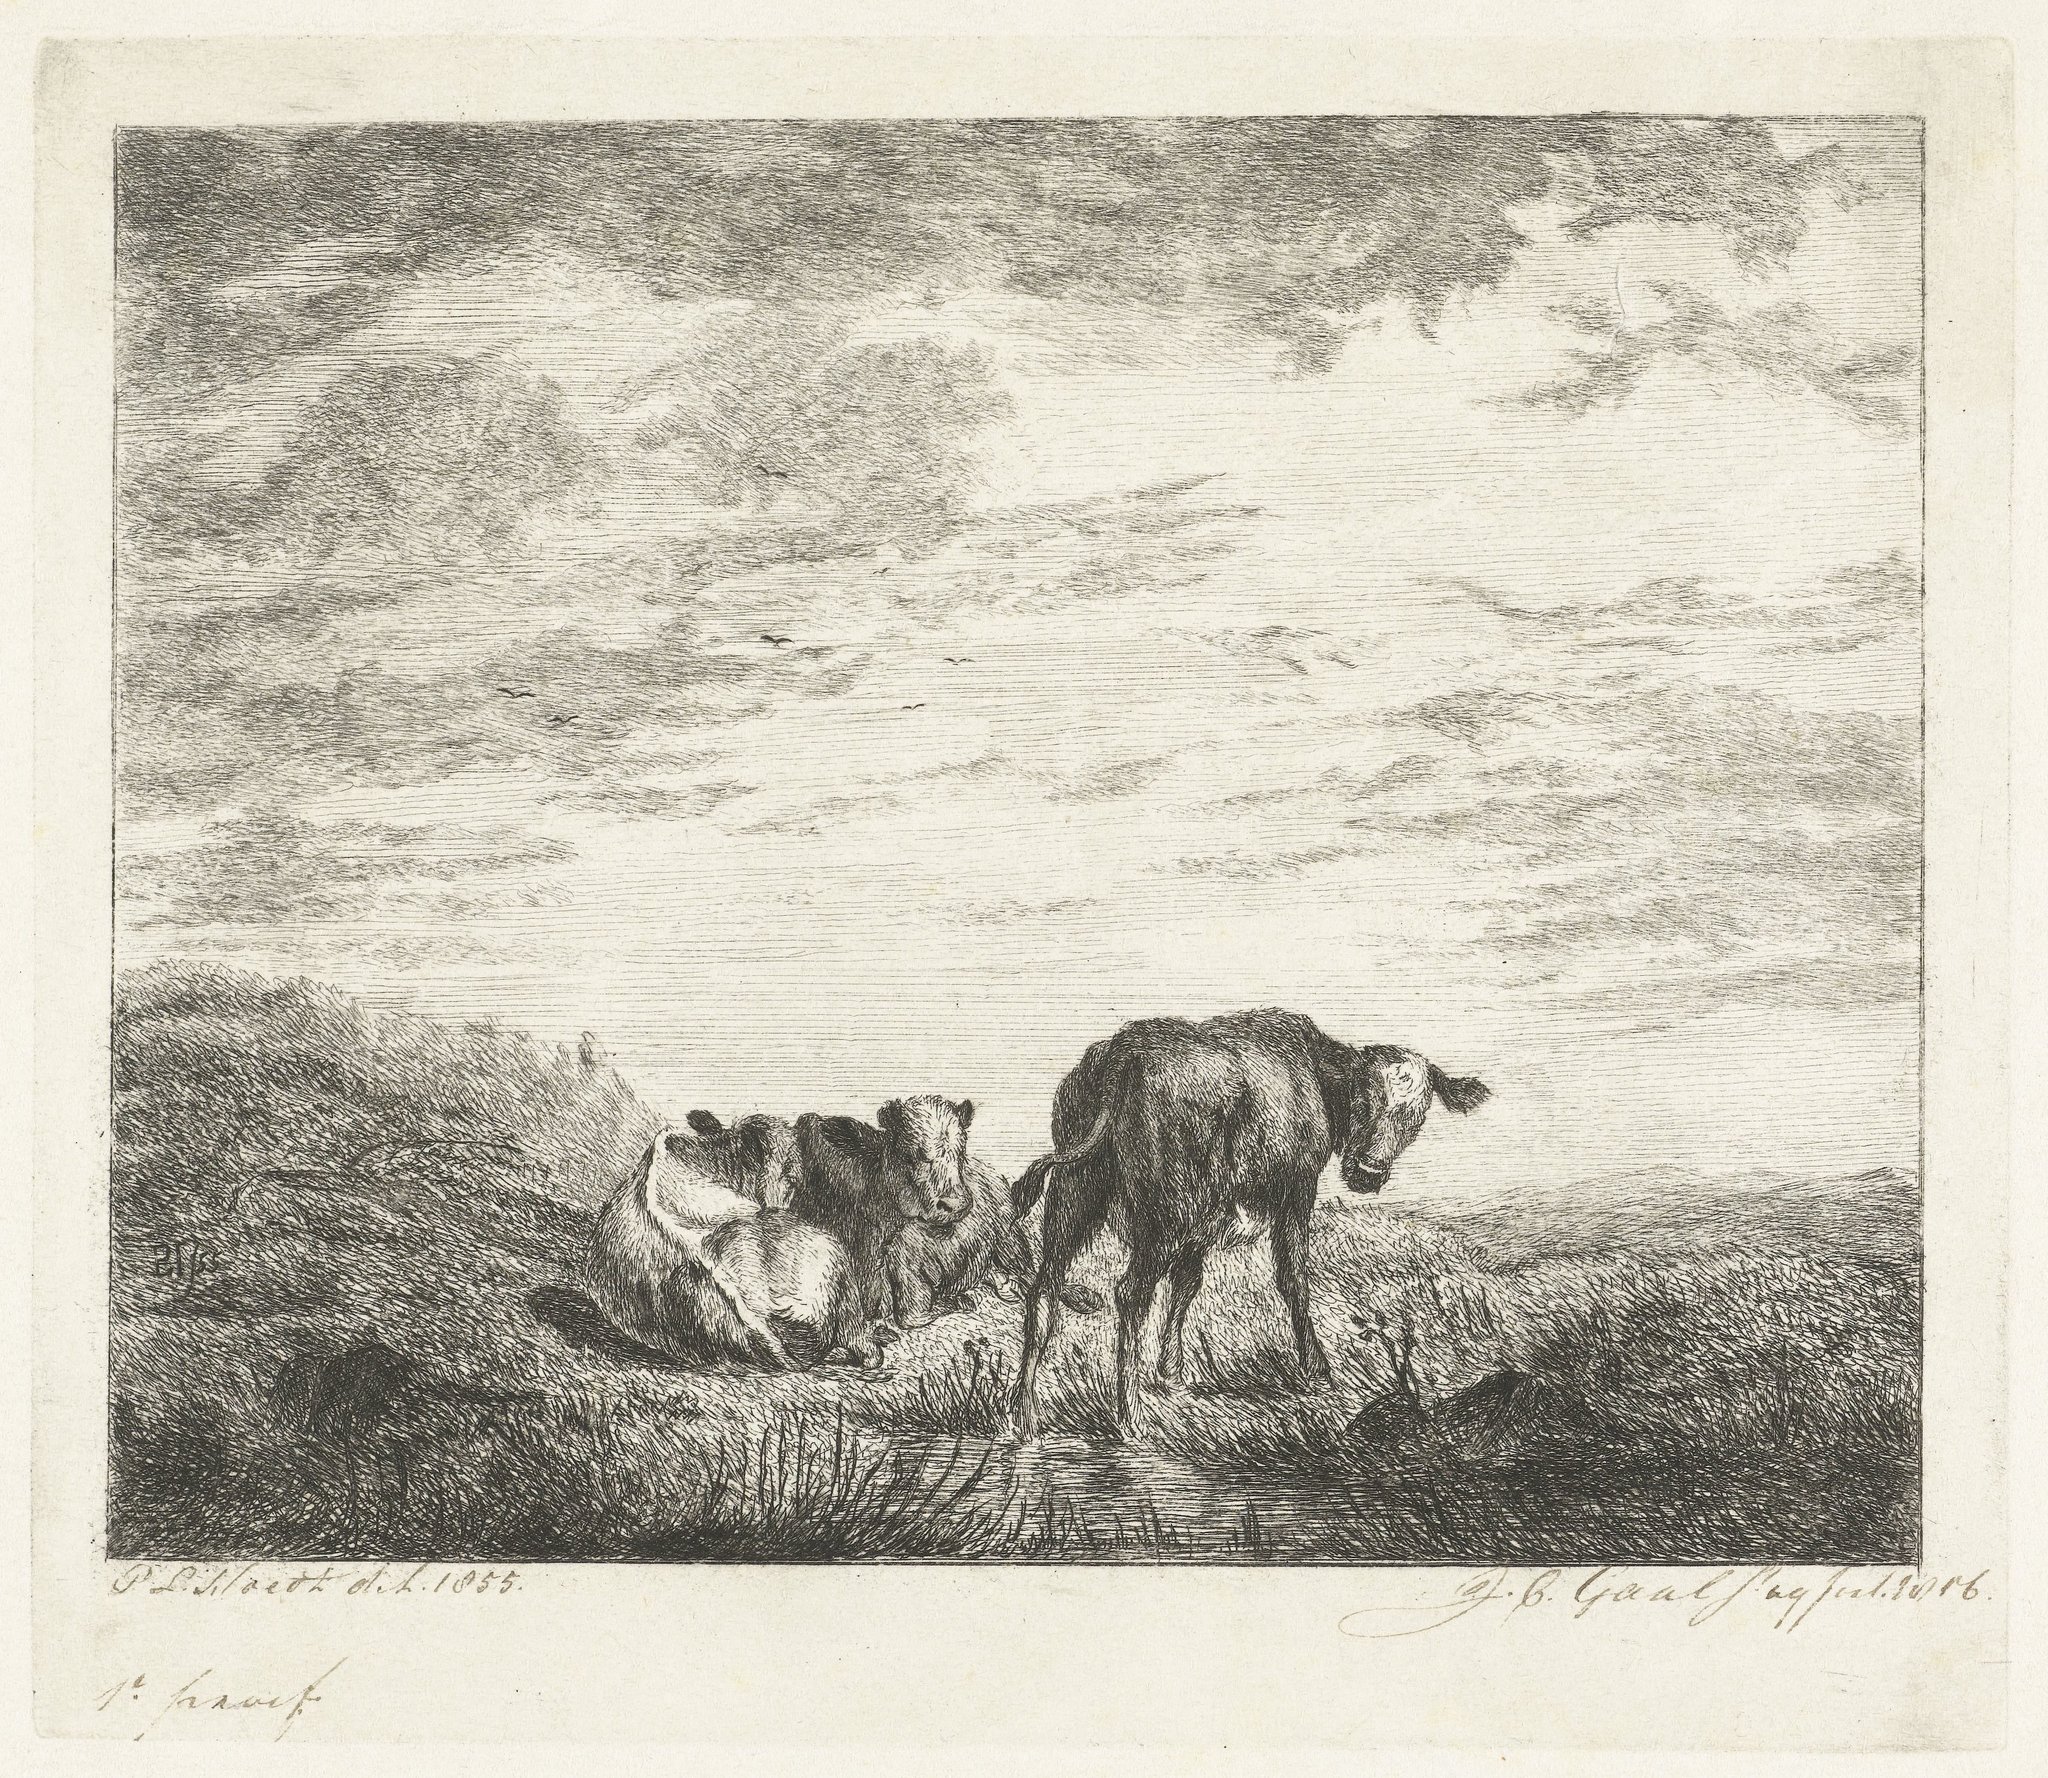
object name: print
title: Drie kalveren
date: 1856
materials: paper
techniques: etching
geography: netherlands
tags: calf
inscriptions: collector's mark: Lugt 2228